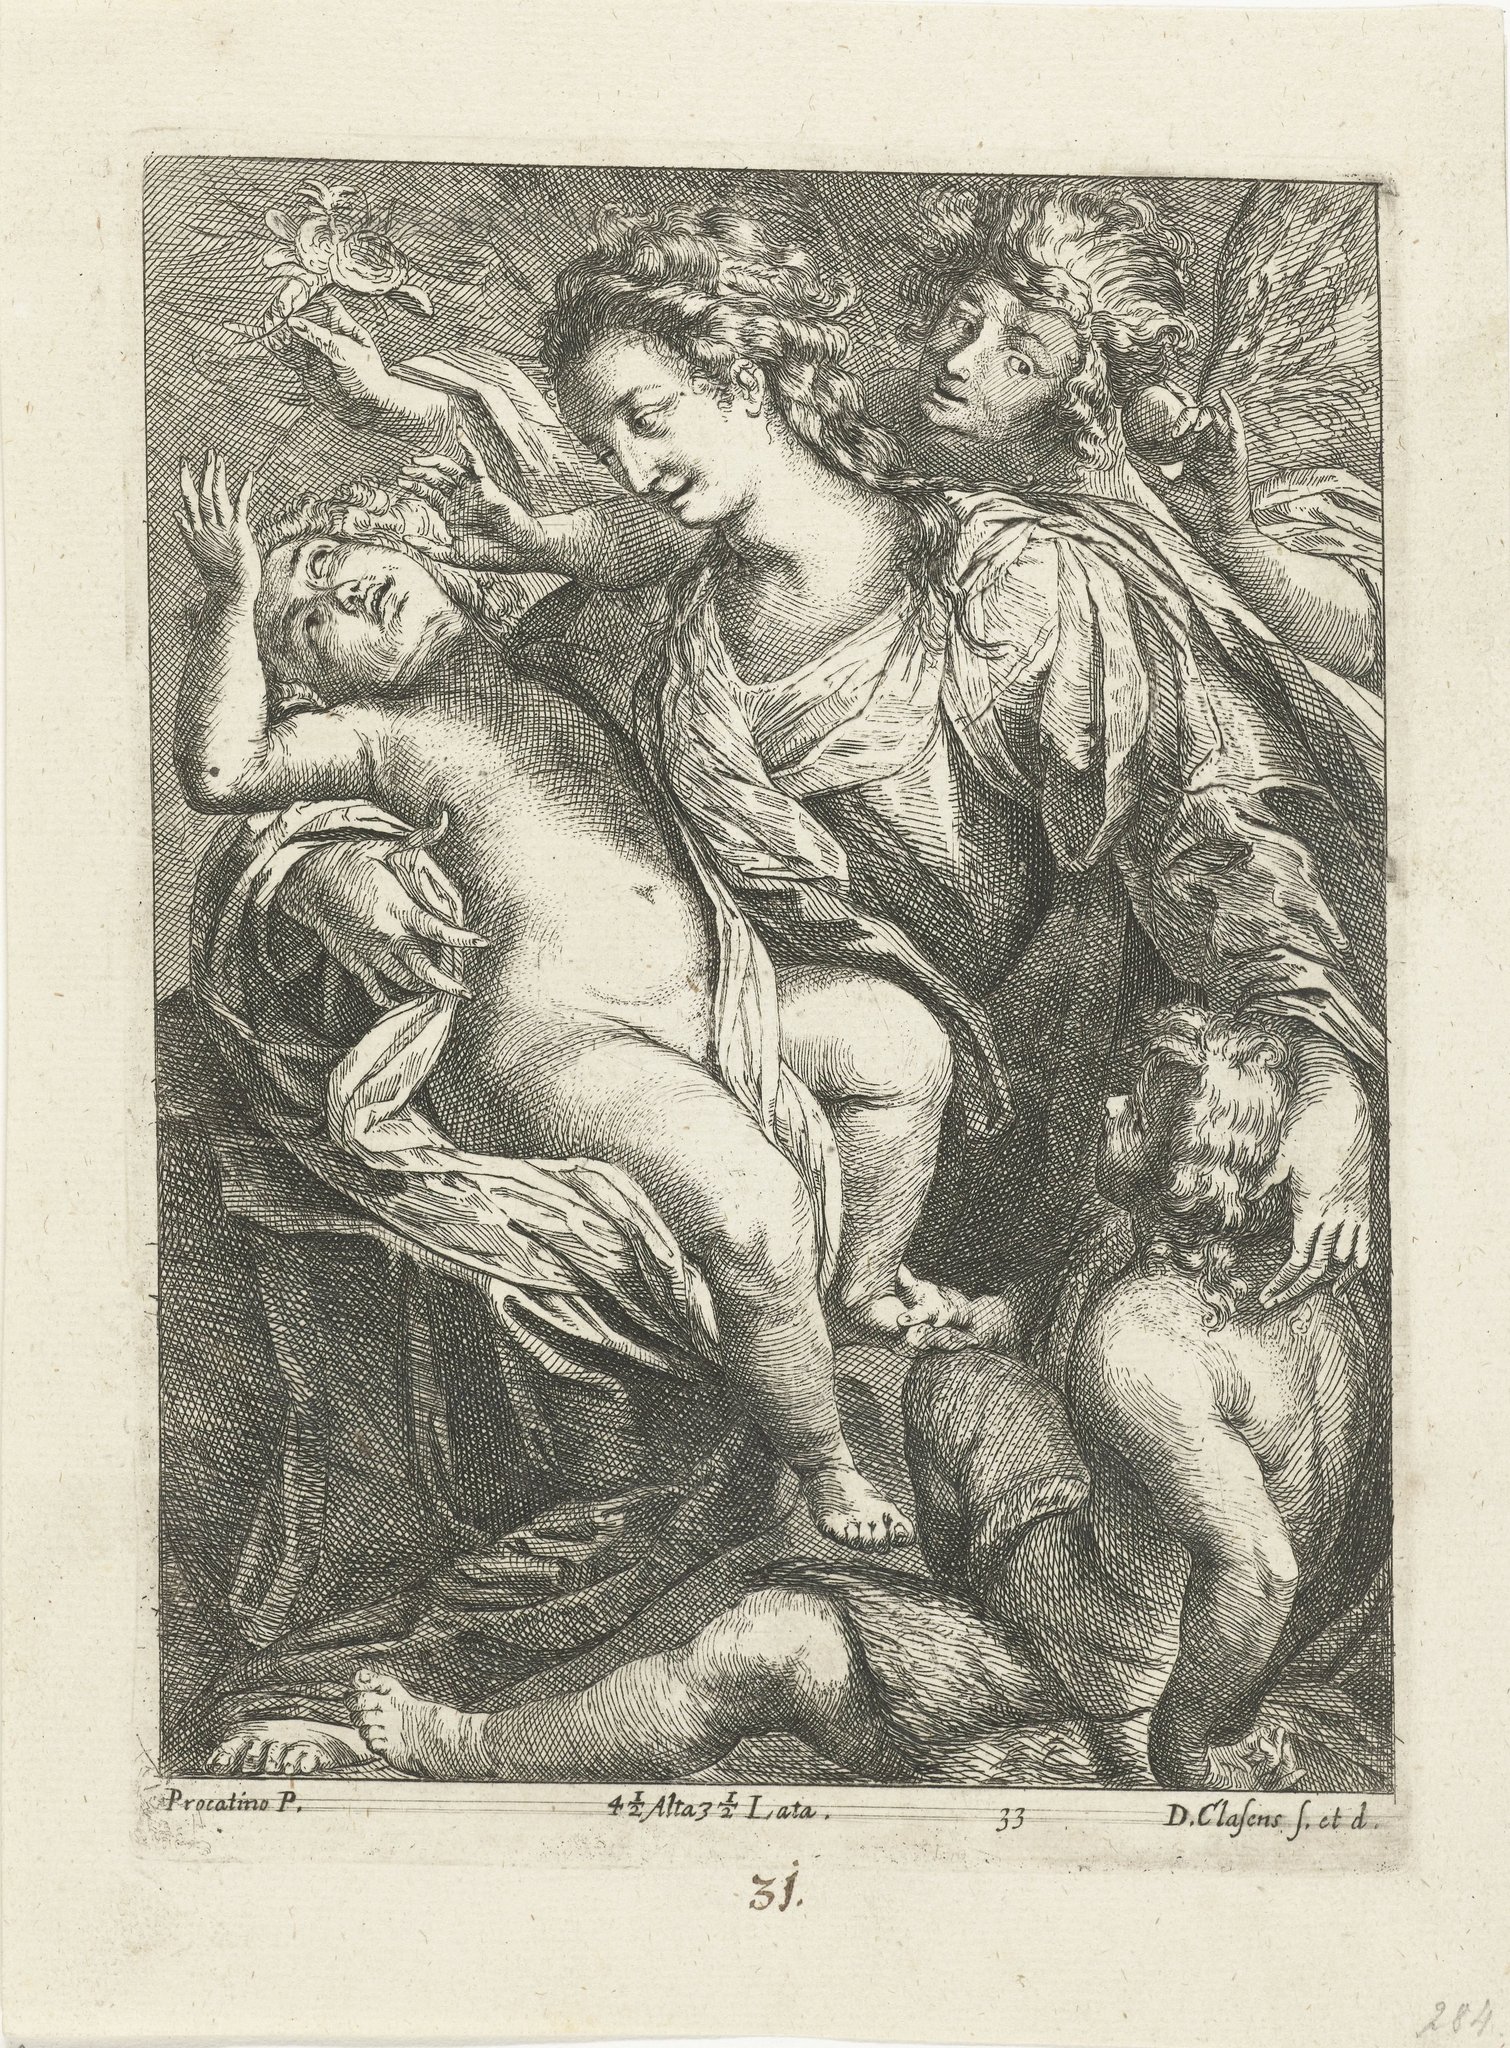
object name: print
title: Maria met Christus en Johannes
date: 1650-1670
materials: paper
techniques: engraving, etching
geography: italy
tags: mary sitting on the ground, the christ-child in front of her, sitting in her lap, mary and the christ-child with john the baptist (as child) (+ angel(s))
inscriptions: collector's mark: Lugt 2228, number: ‘31’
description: Maria zit en draagt het Christuskind in haar armen. Johannes de Doper zit naast haar. Zowel Christus als Johannes zijn tussen de drie en de vijf jaar oud. Een engel die zich achter Maria bevindt, geeft het Christuskind een bloem. In de andere hand heeft de engel een appel. Het formaat van het oorspronkelijke schilderij staat in het Latijn vermeld.